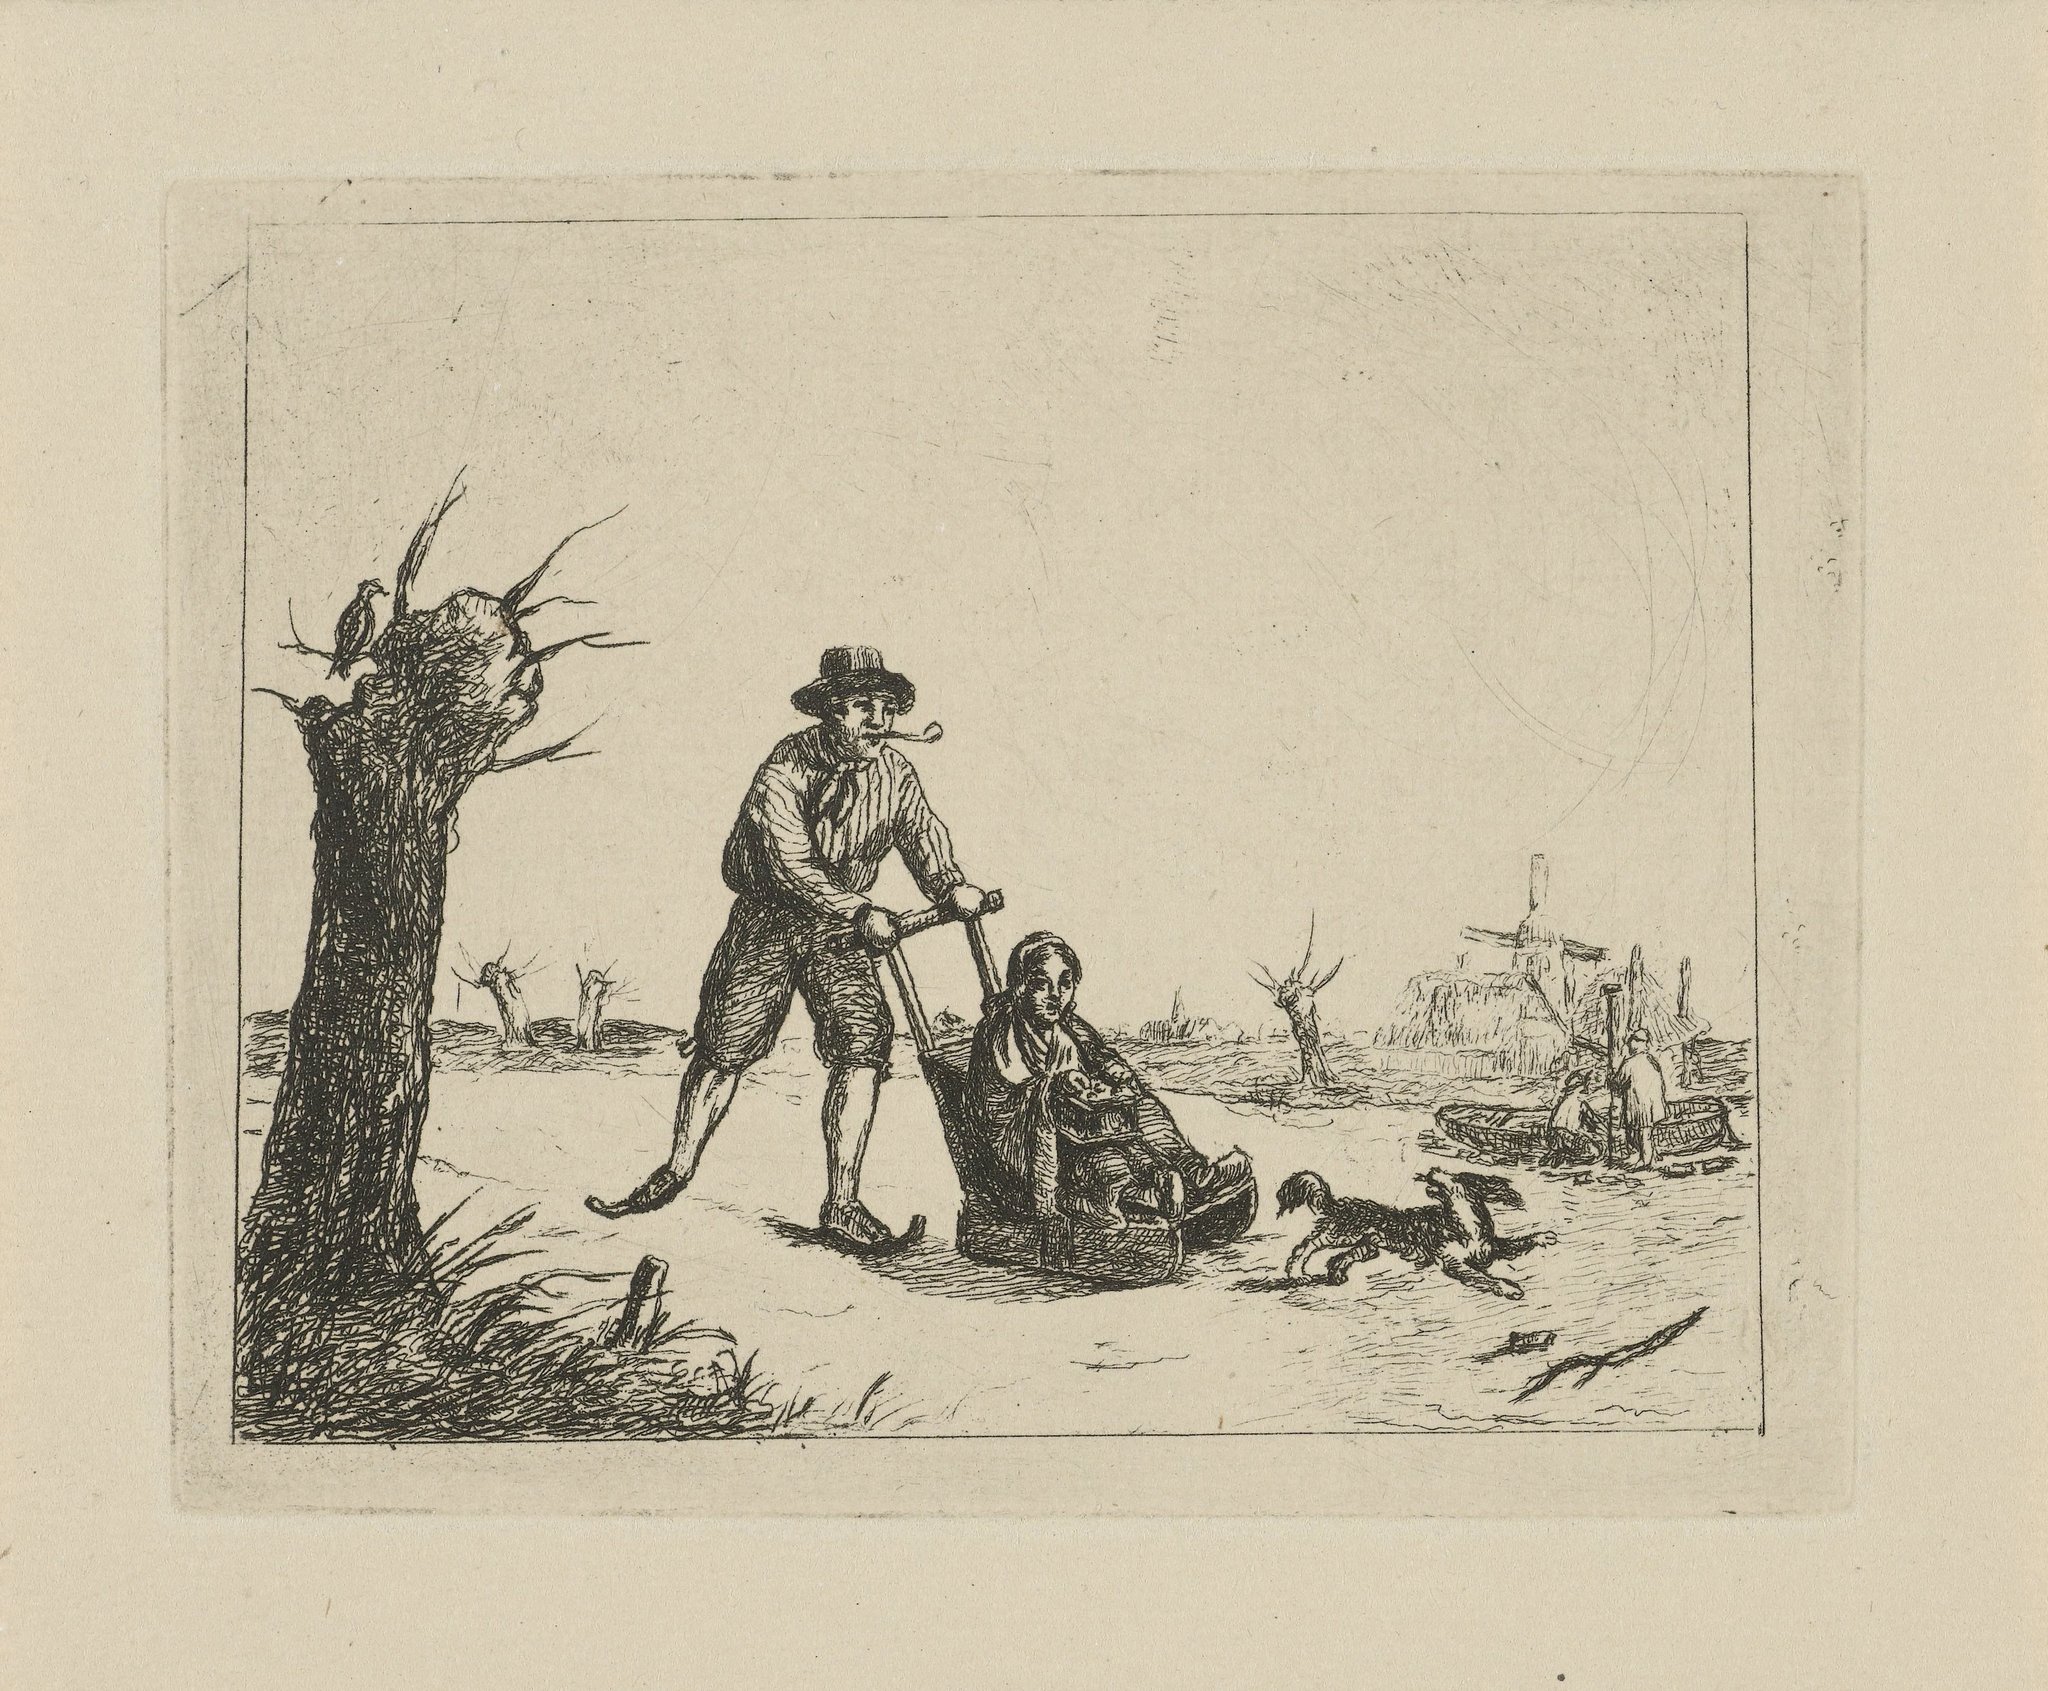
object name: print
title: Winterlandschap met schaatser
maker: david van der kellen (1804-1879)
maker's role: die cutter, draughtsman, print maker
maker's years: 1804-1879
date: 1814-1878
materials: paper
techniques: drypoint, etching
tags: rowing-boat, canoe, etc., winter landscape; landscape symbolizing winter (the four seasons of the year), windmill in landscape, skates (winter sports), sledge, sleigh (winter sports), dog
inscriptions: collector's mark: Lugt 2228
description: In een winterlandschap duwt een pijprokende man met hoed op zijn schaatsen een slede voort met daarin een meisje. Voor de slee rent een hond. Op de achtergrond staan twee mannen bij een boot en is een windmolen te zien.